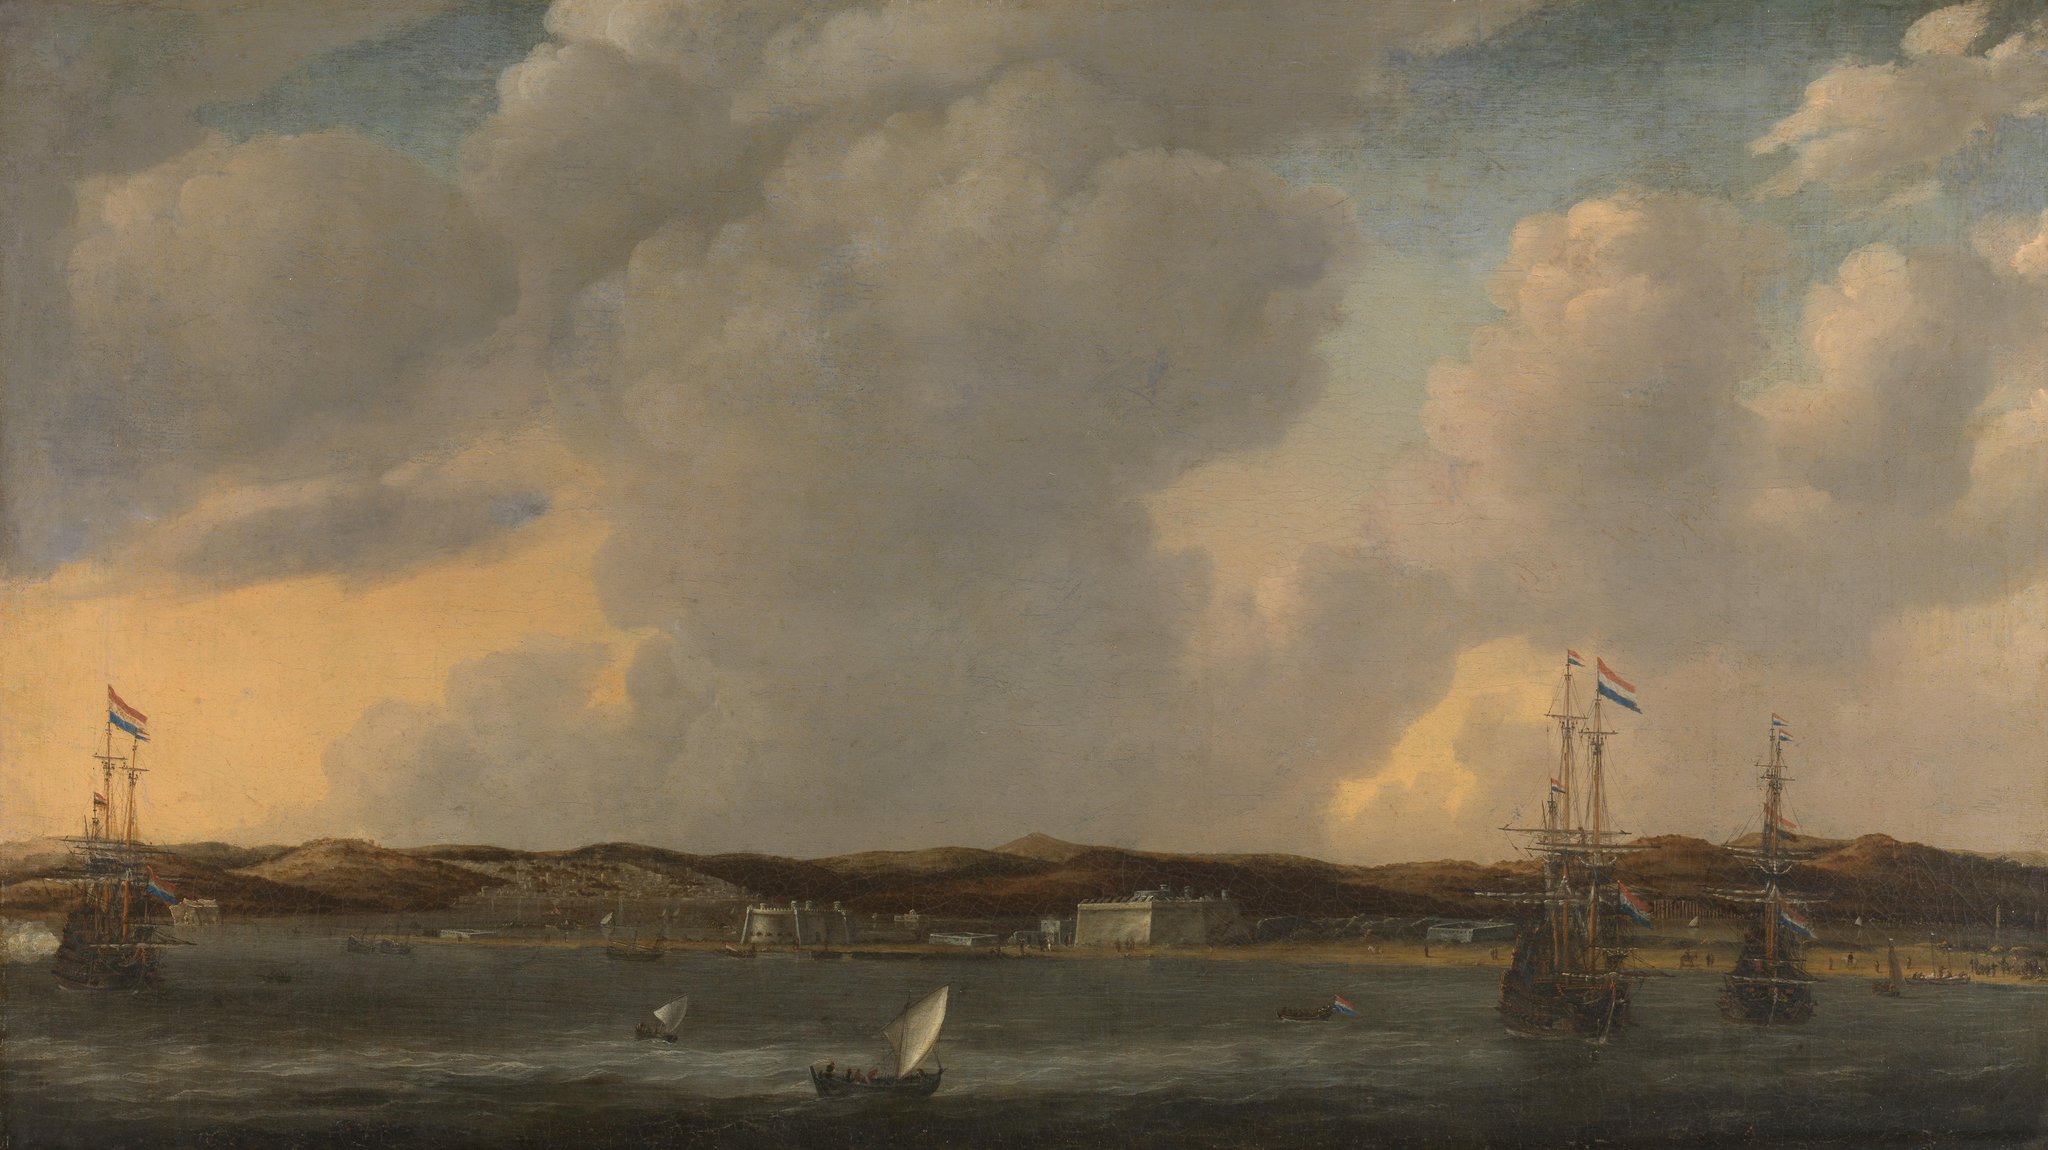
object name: painting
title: View of Tunis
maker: reinier nooms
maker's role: draughtsman, painter, print maker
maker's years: 1623-1664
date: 1662-1668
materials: canvas, oil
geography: amsterdam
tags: sailing-ship, sailing-boat, coast, navy (+ sailing-ships)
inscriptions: signature, on a flag: ‘R. Zeeman’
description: In the second half of the seventeenth century, Tunis was a haven for pirates and privateers who lay in wait for Dutch merchant ships. To protect Dutch merchantmen, the navy patrolled the Mediterranean Sea. Nooms painted the ships and the topography of the shore with remarkable detail. He probably used drawings made on site as inspiration for this painting.